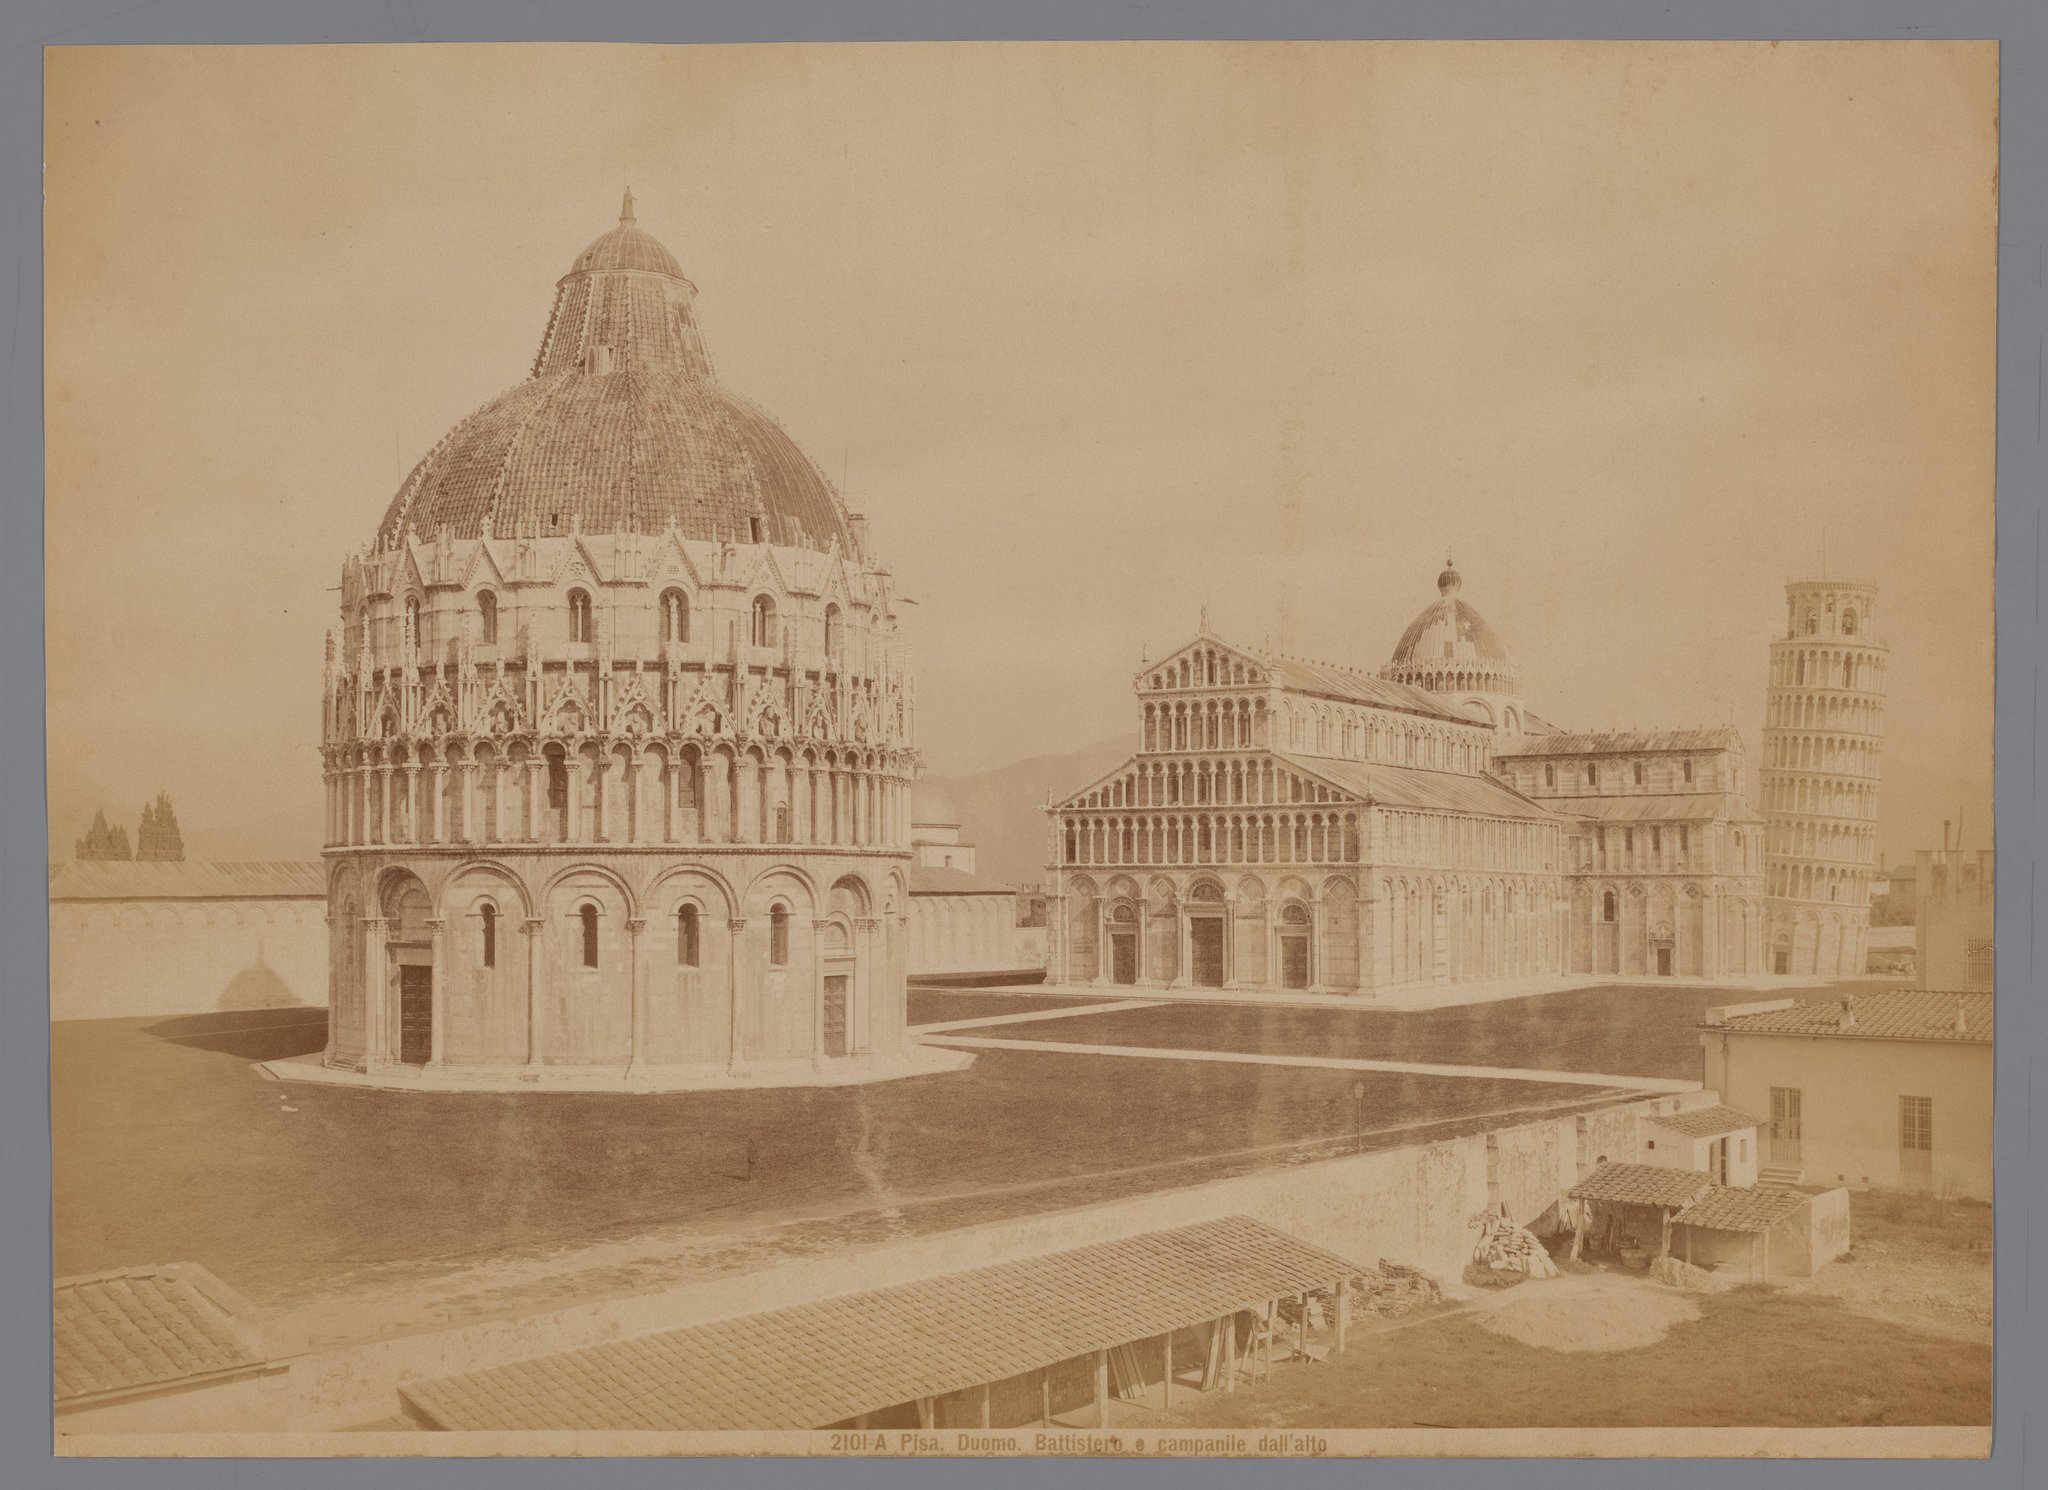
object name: photograph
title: Baptisterium, de kathedraal en de Toren van Pisa, Italië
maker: Anonymous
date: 1851-1900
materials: paper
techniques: albumen print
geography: pisa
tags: parts of church exterior and annexes: campanile, church (exterior)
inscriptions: number: ‘2101 A’